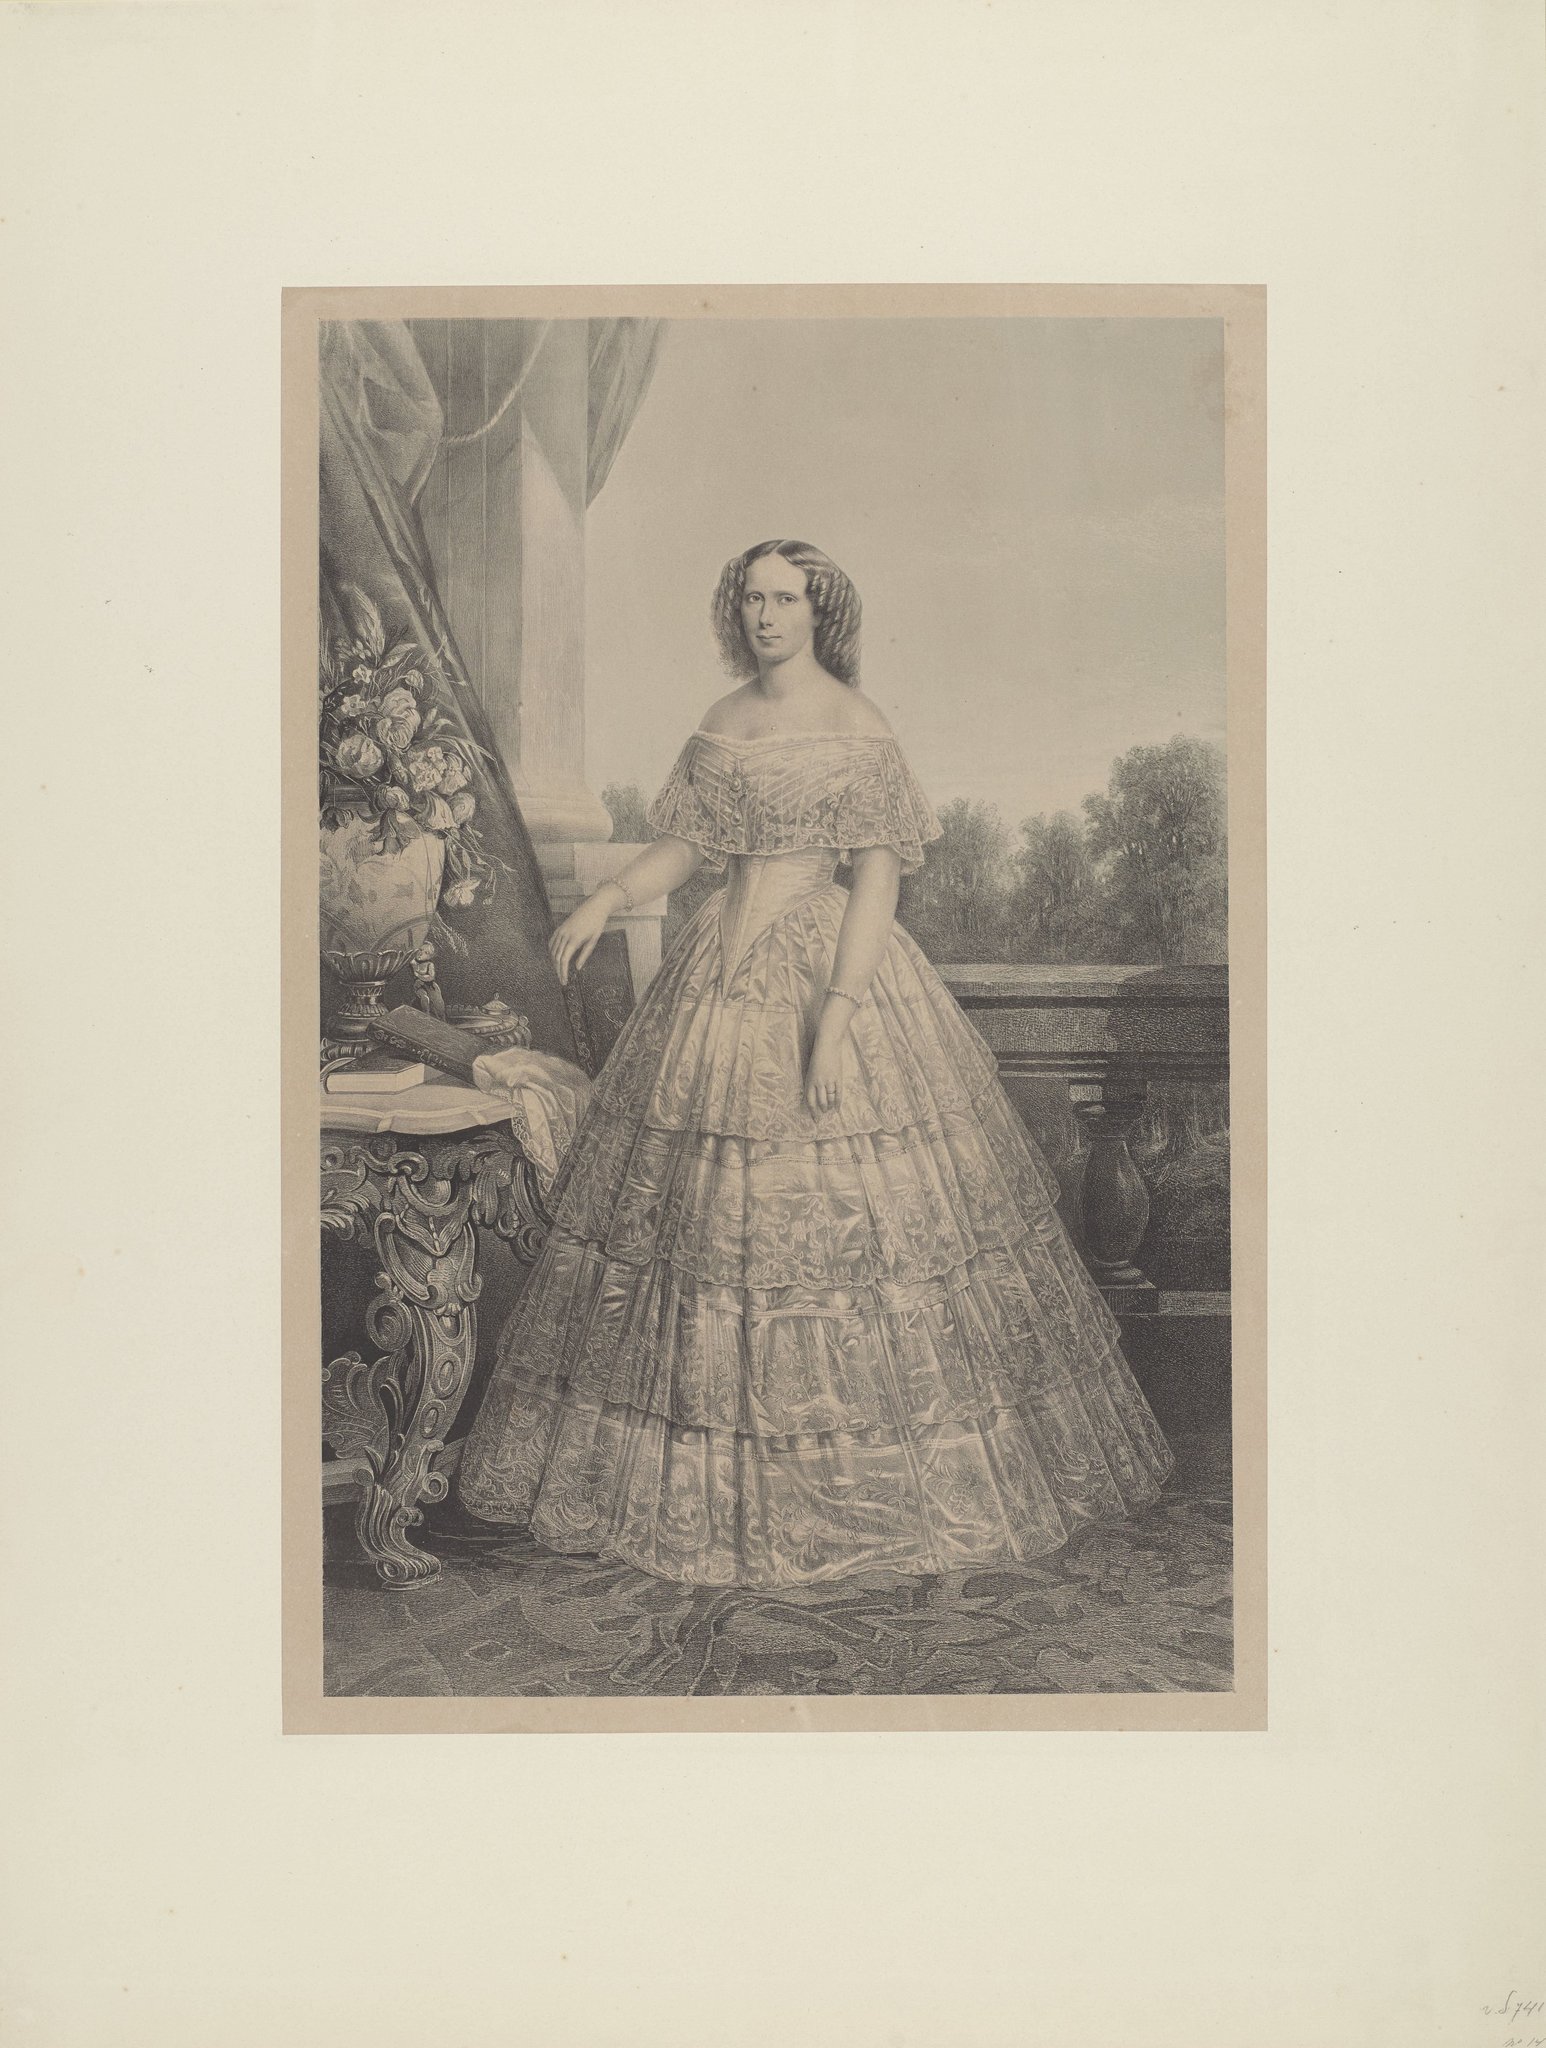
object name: print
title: Portret van Sophie van Württemberg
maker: Anonymous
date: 1849-1871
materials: paper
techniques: lithograph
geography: the hague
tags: the hague, sophia frederika mathilda van württemberg, historical persons - bb - woman, ruler, sovereign - bb - female ruler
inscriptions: collector's mark: Lugt 963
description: Portret van Sophie. Ze staat naast een tafel met daarop een vaas en twee boeken. Op de achtergrond een park.